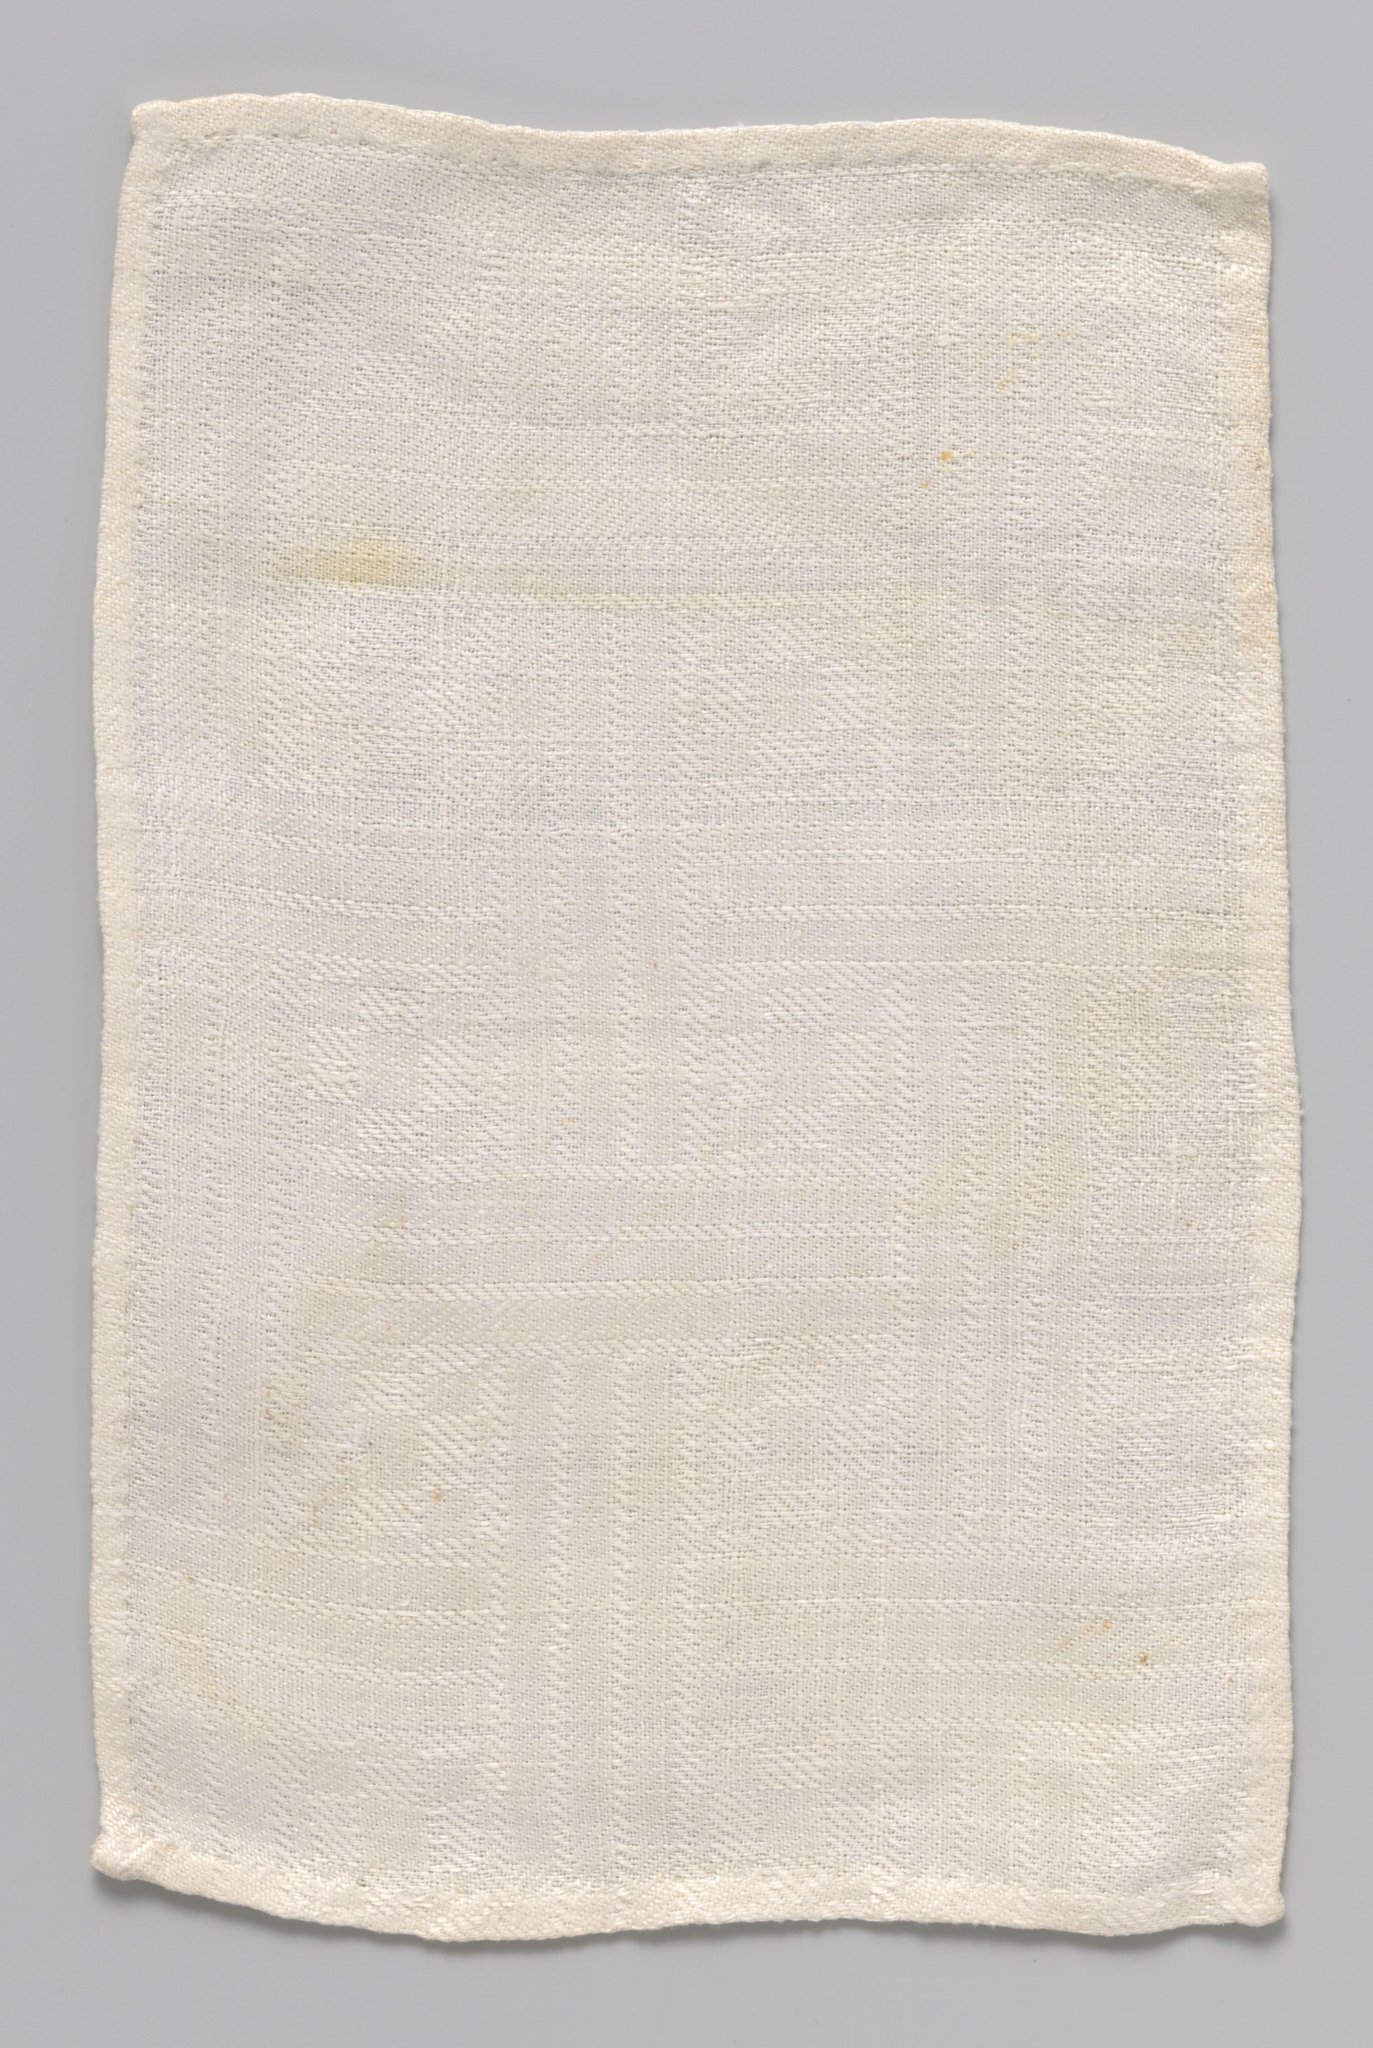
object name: poppengoed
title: Witte rechthoekige doek met ingeweven geometrisch patroon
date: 1836-1898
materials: textile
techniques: weave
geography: netherlands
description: BK-15446-13 t/m 16 en BK-2021-152 hebben hetzelfde ingeweven geometrische patroon.